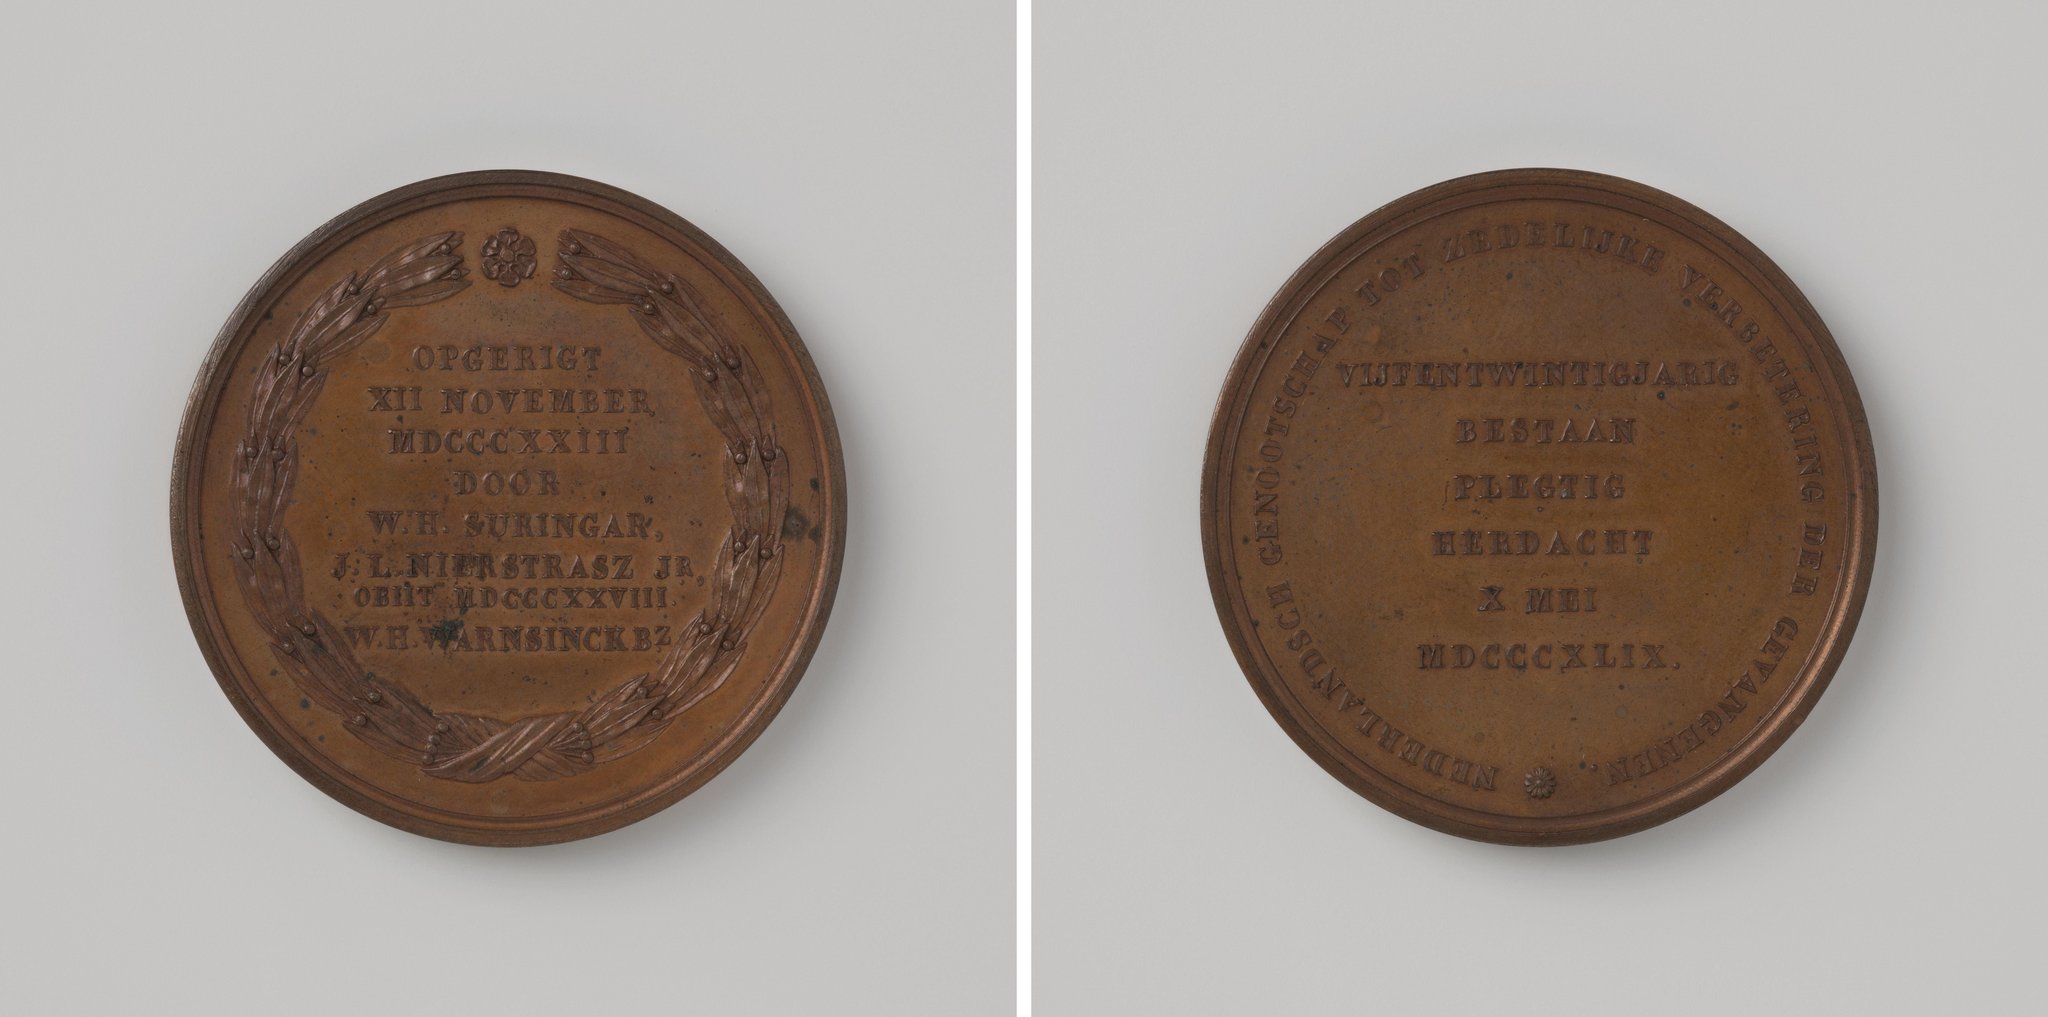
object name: history medal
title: Vijfentwintigjarig bestaan van het Nederlandsch Genootschap tot Zedelijke Verbetering van Gevangenen 1849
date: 1849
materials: bronze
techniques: striking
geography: utrecht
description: Bronzen penning, op de voorzijde zes regels tekst met omschrift, op de keerzijde acht regels tekst binnen een lauwerkrans.